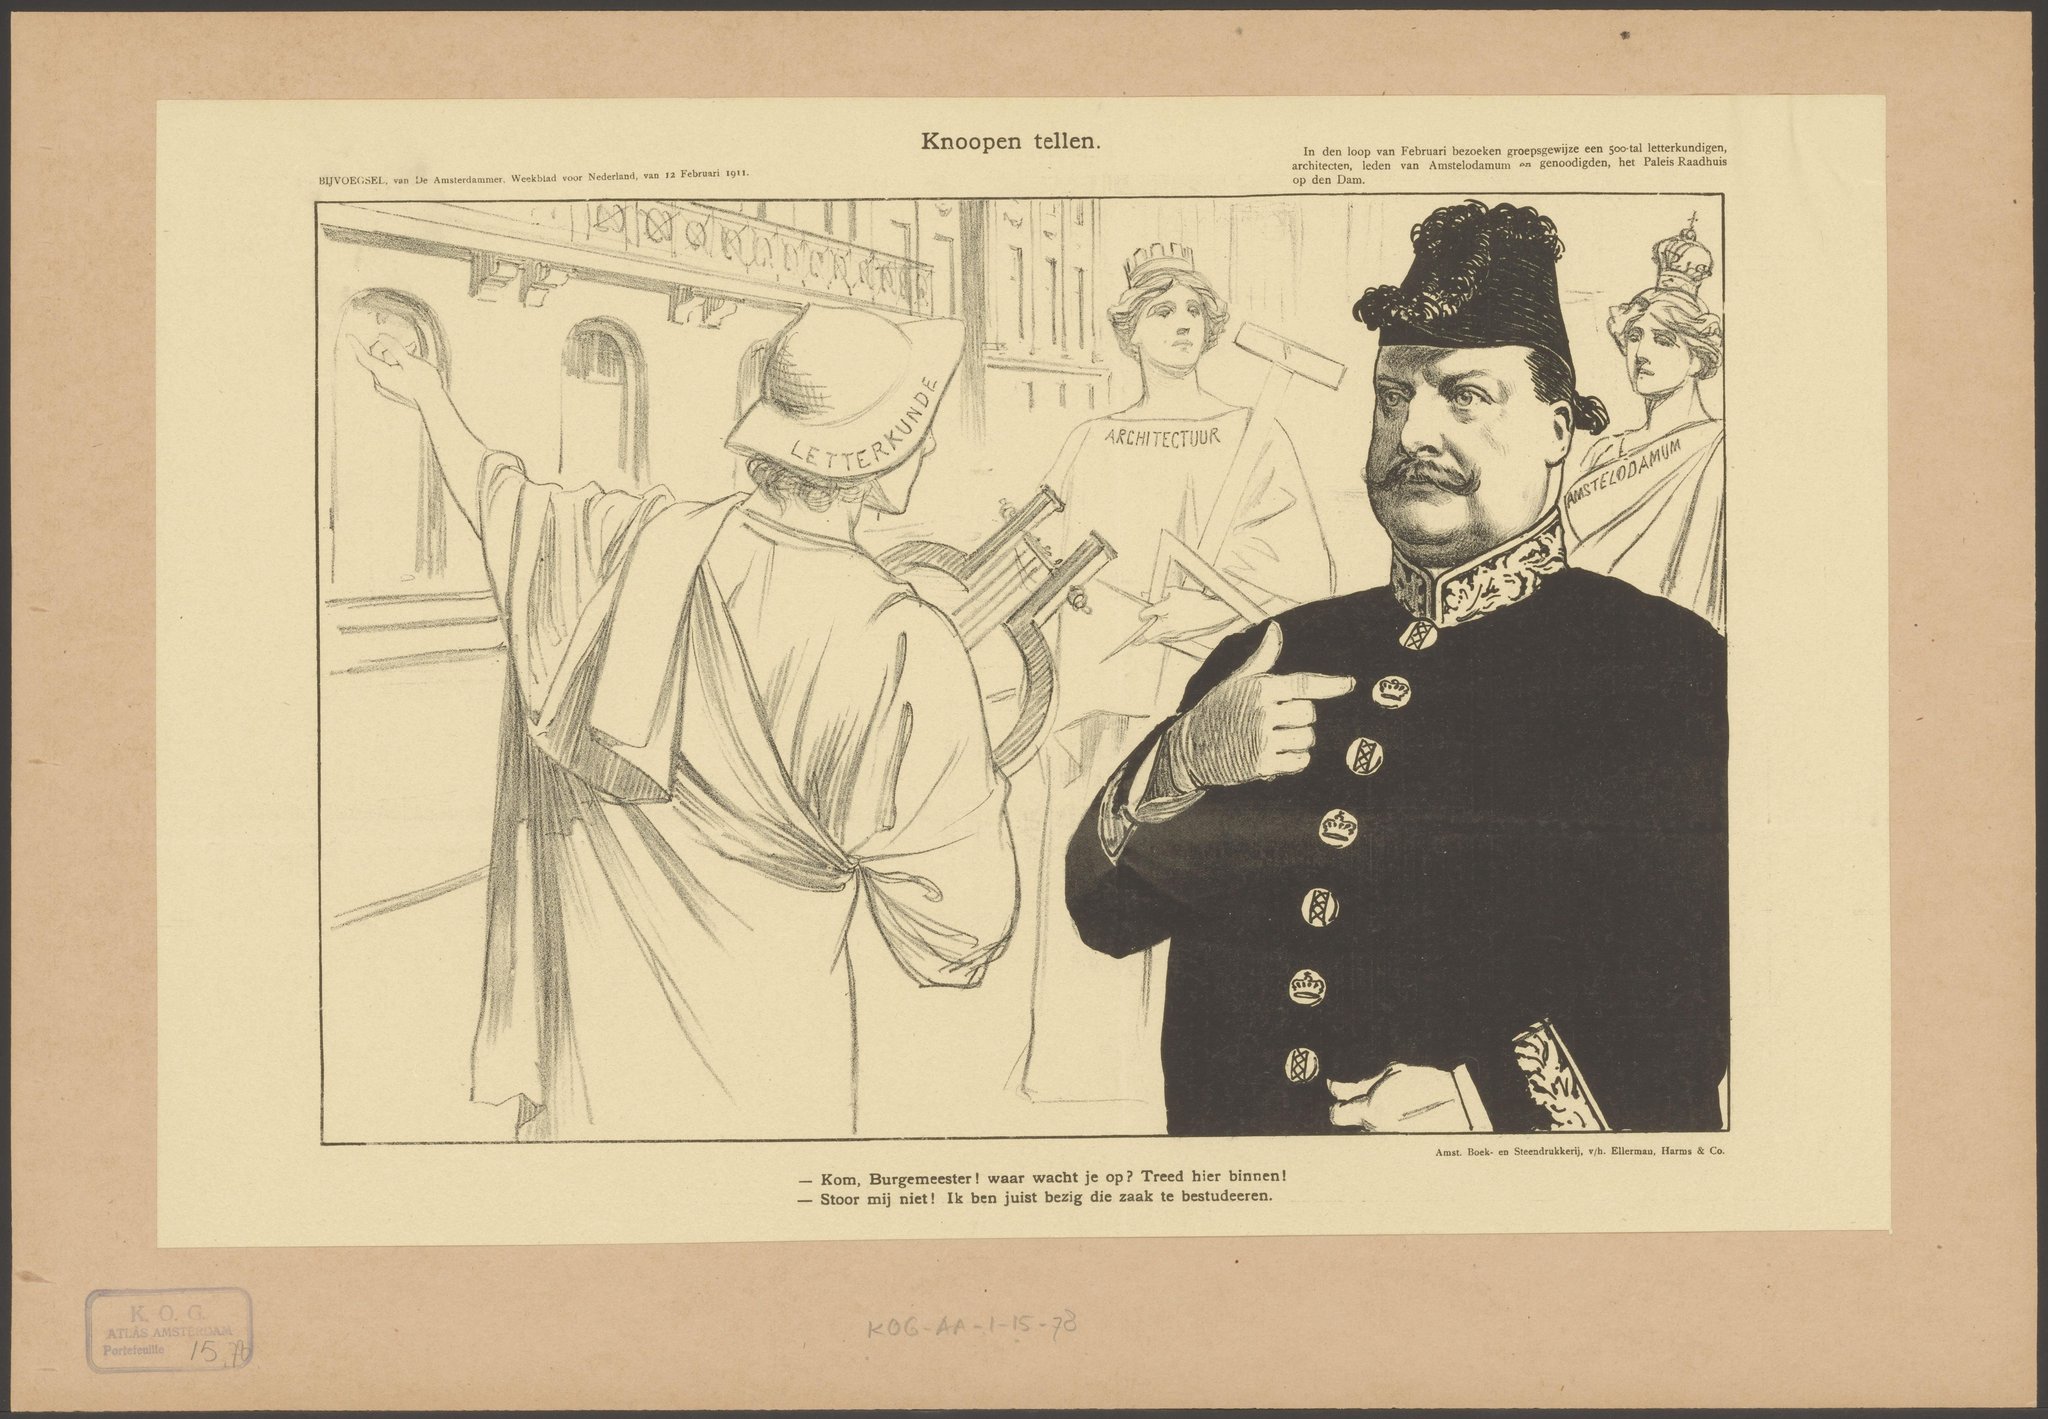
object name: cartoon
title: Knoopen tellen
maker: Anonymous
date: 1911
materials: paper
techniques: letterpress printing, lithograph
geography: amsterdam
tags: city-view in general; 'veduta', palace, townhall, royal palace of amsterdam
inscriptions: collector's mark: ‘15,78’ Lugt 1641b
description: Onderwerpsrubriek binnen de Atlas Amsterdam: Nieuwe Stadhuis op de Dam, van buiten, Kleine steentjes kwestie, Paleis - Raadhuiskwestie.